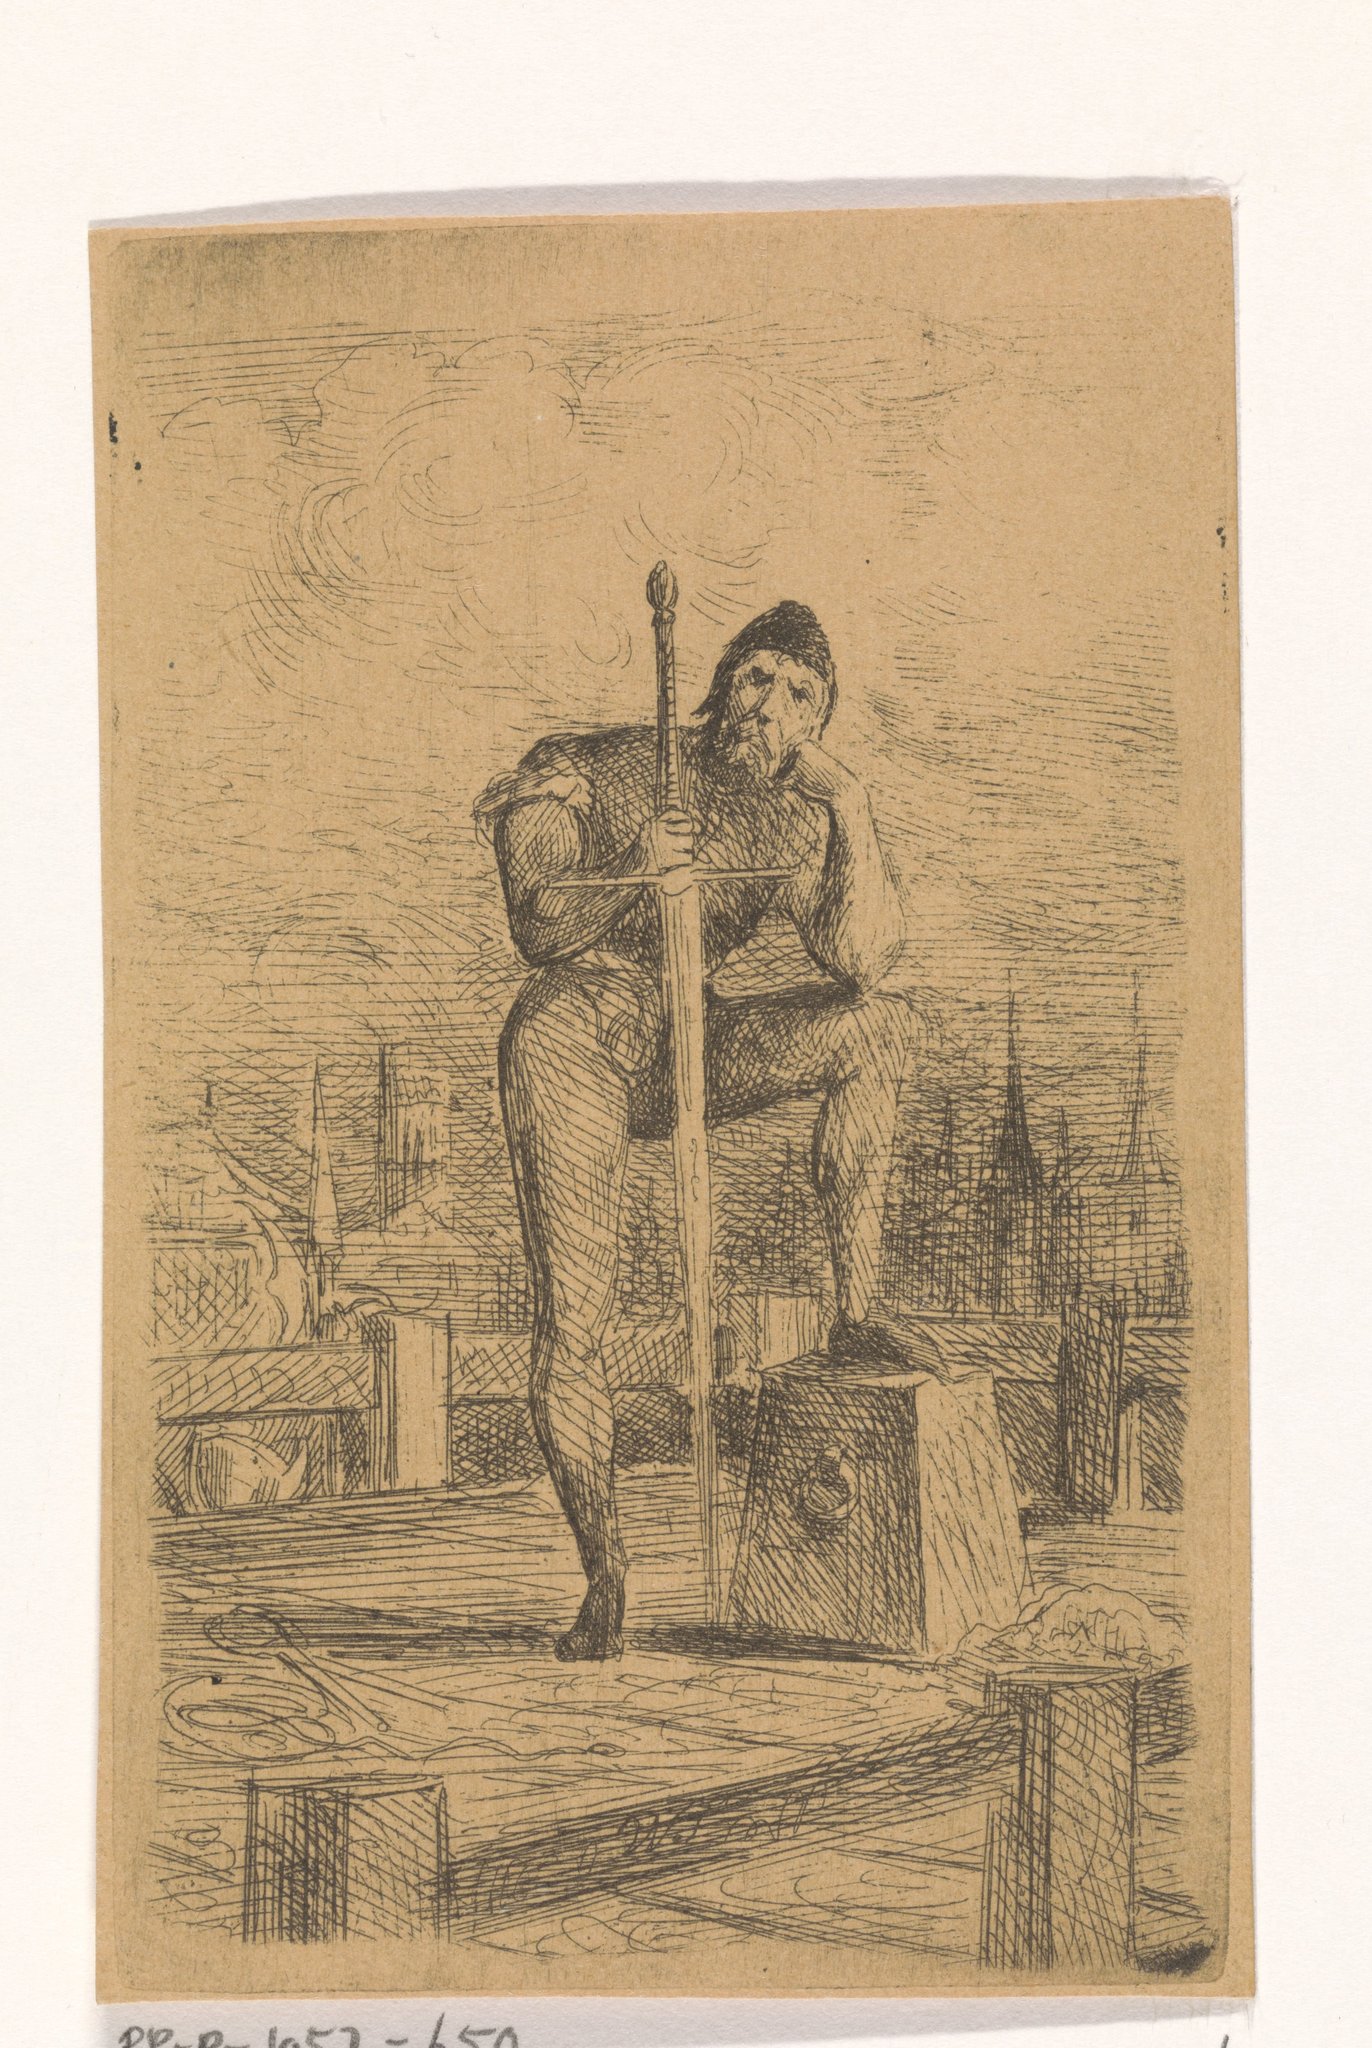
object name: print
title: Beul met zwaard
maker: willem de famars testas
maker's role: draughtsman, painter, print maker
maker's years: 1834-1896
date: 1844-1896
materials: paper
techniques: etching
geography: netherlands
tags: hacking and thrusting weapons: sword, executioner, hangman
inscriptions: collector's mark: Lugt 2228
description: Een beul met een voet staand op het hakblok het zwaard in zijn hand.